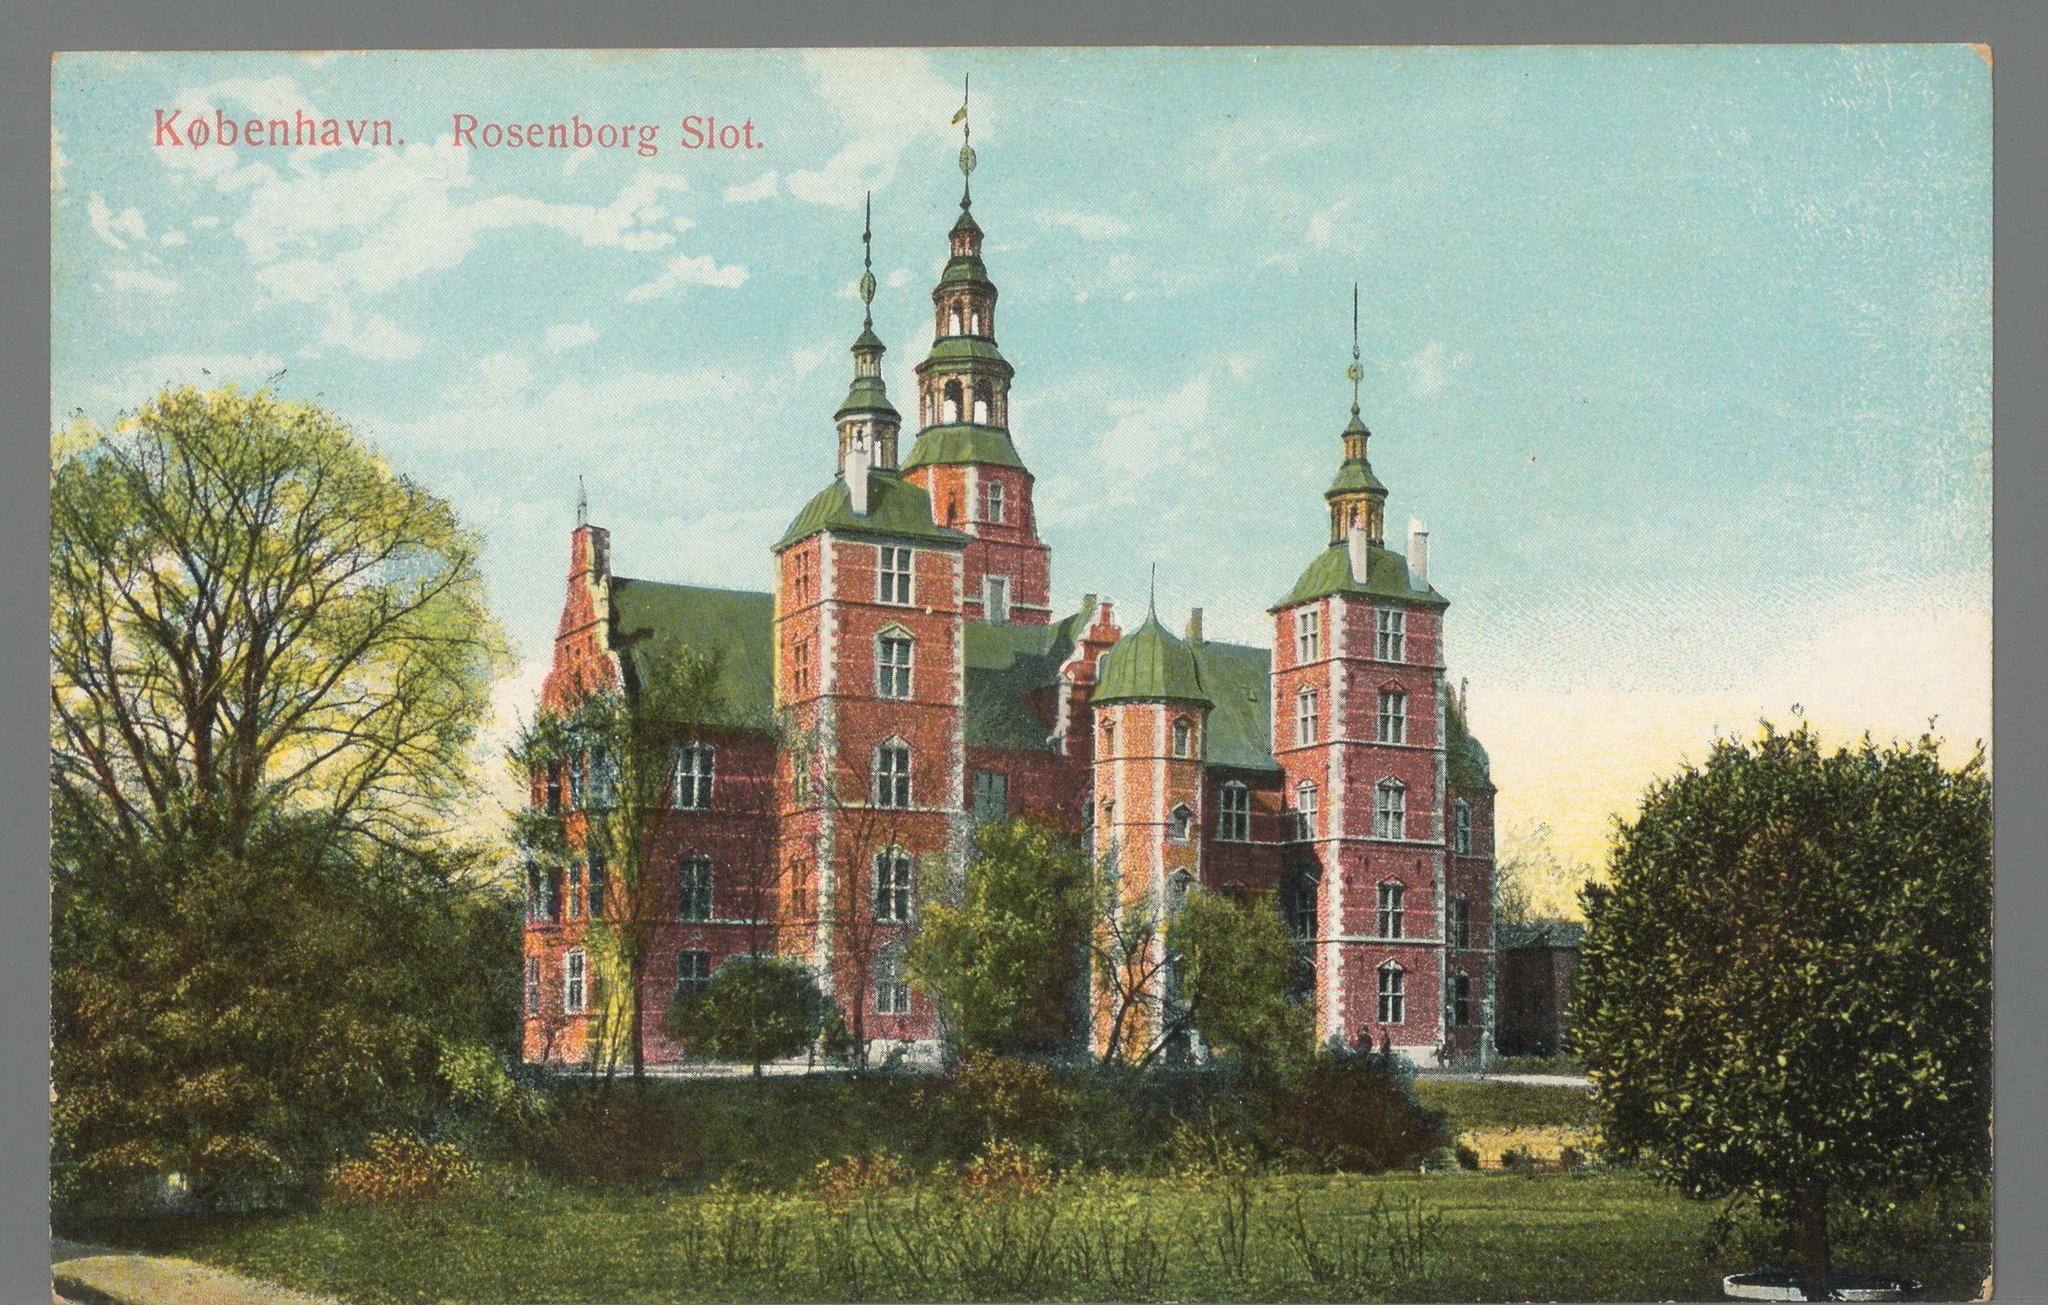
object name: ansichtkaart, prentbriefkaart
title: København. Rosenborg Slot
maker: Anonymous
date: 1906-1920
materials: cardboard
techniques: lithograph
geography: copenhagen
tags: park, palace